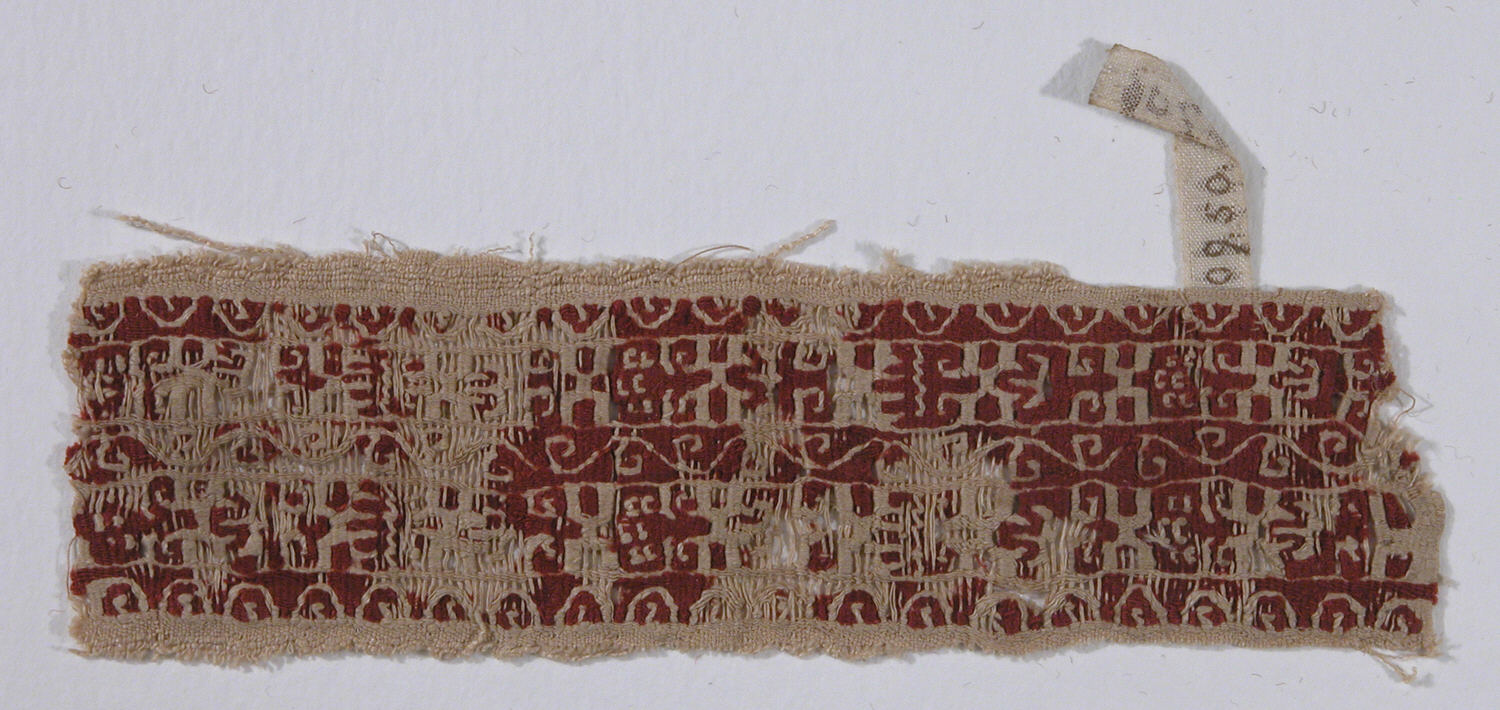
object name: fragment of a sleeve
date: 401-600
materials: linen, wool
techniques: weave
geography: egypt